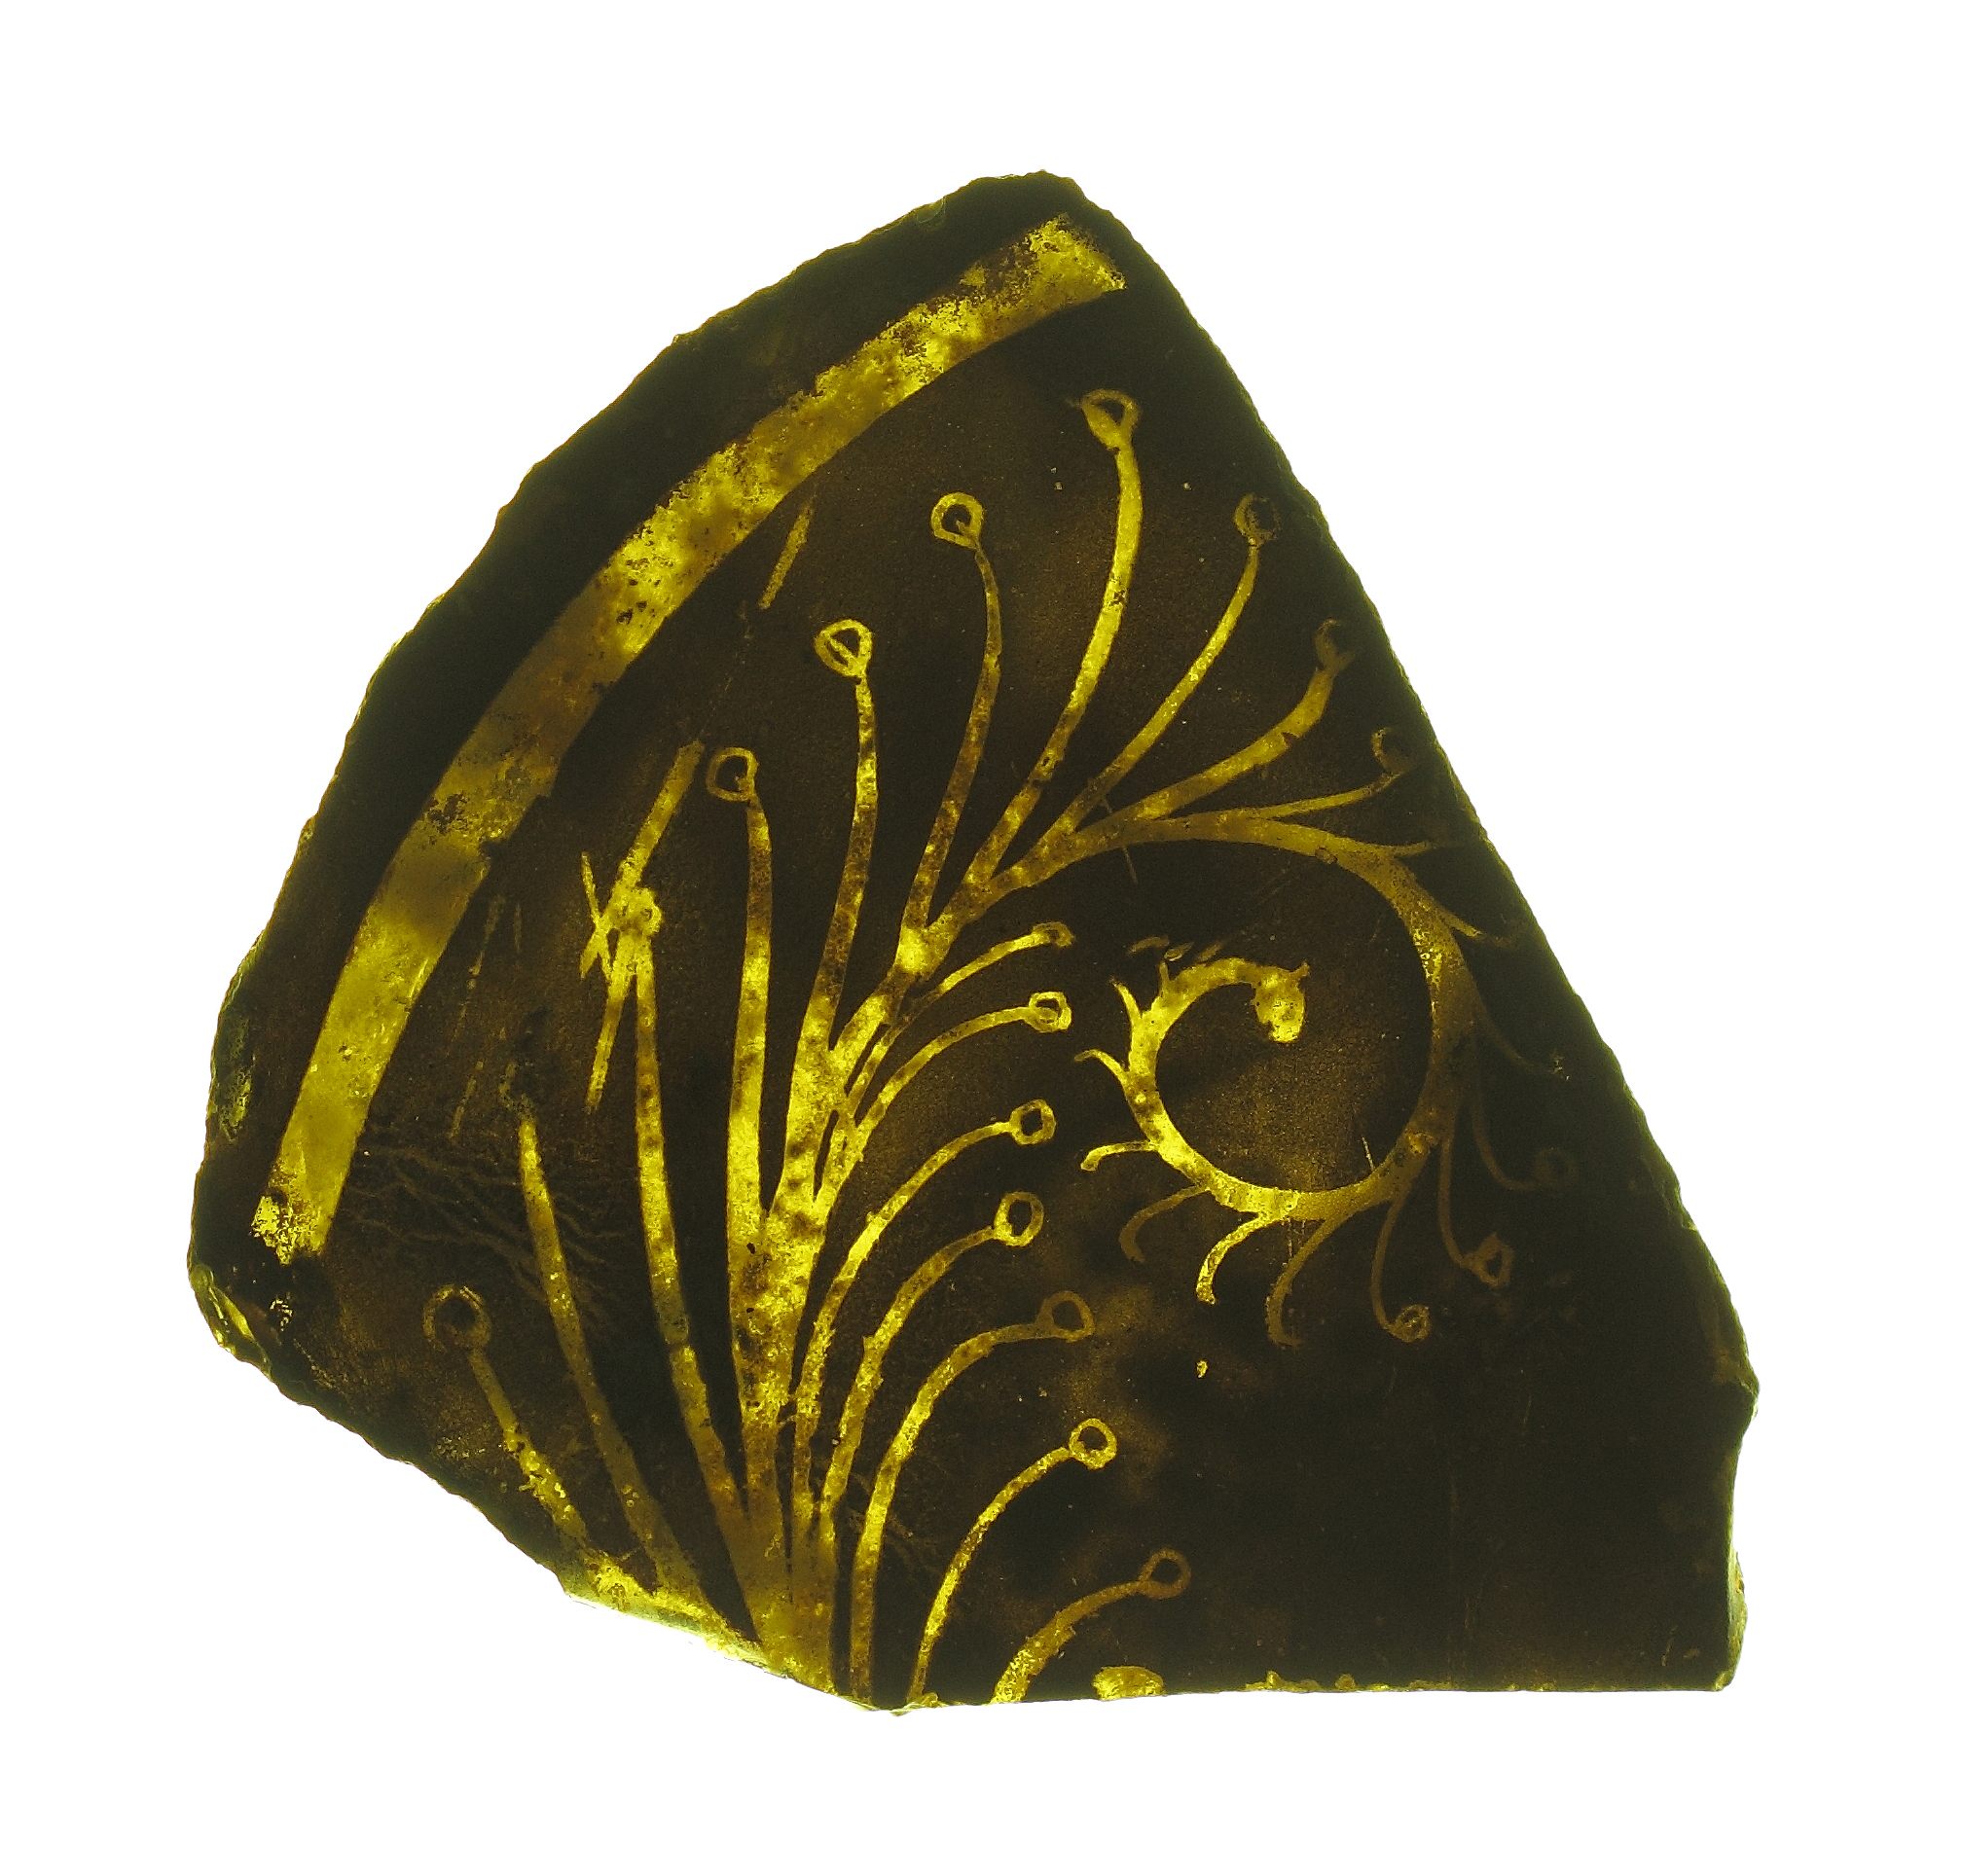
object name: fragment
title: Glass Fragment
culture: french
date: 1201-1300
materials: glass, metal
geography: france